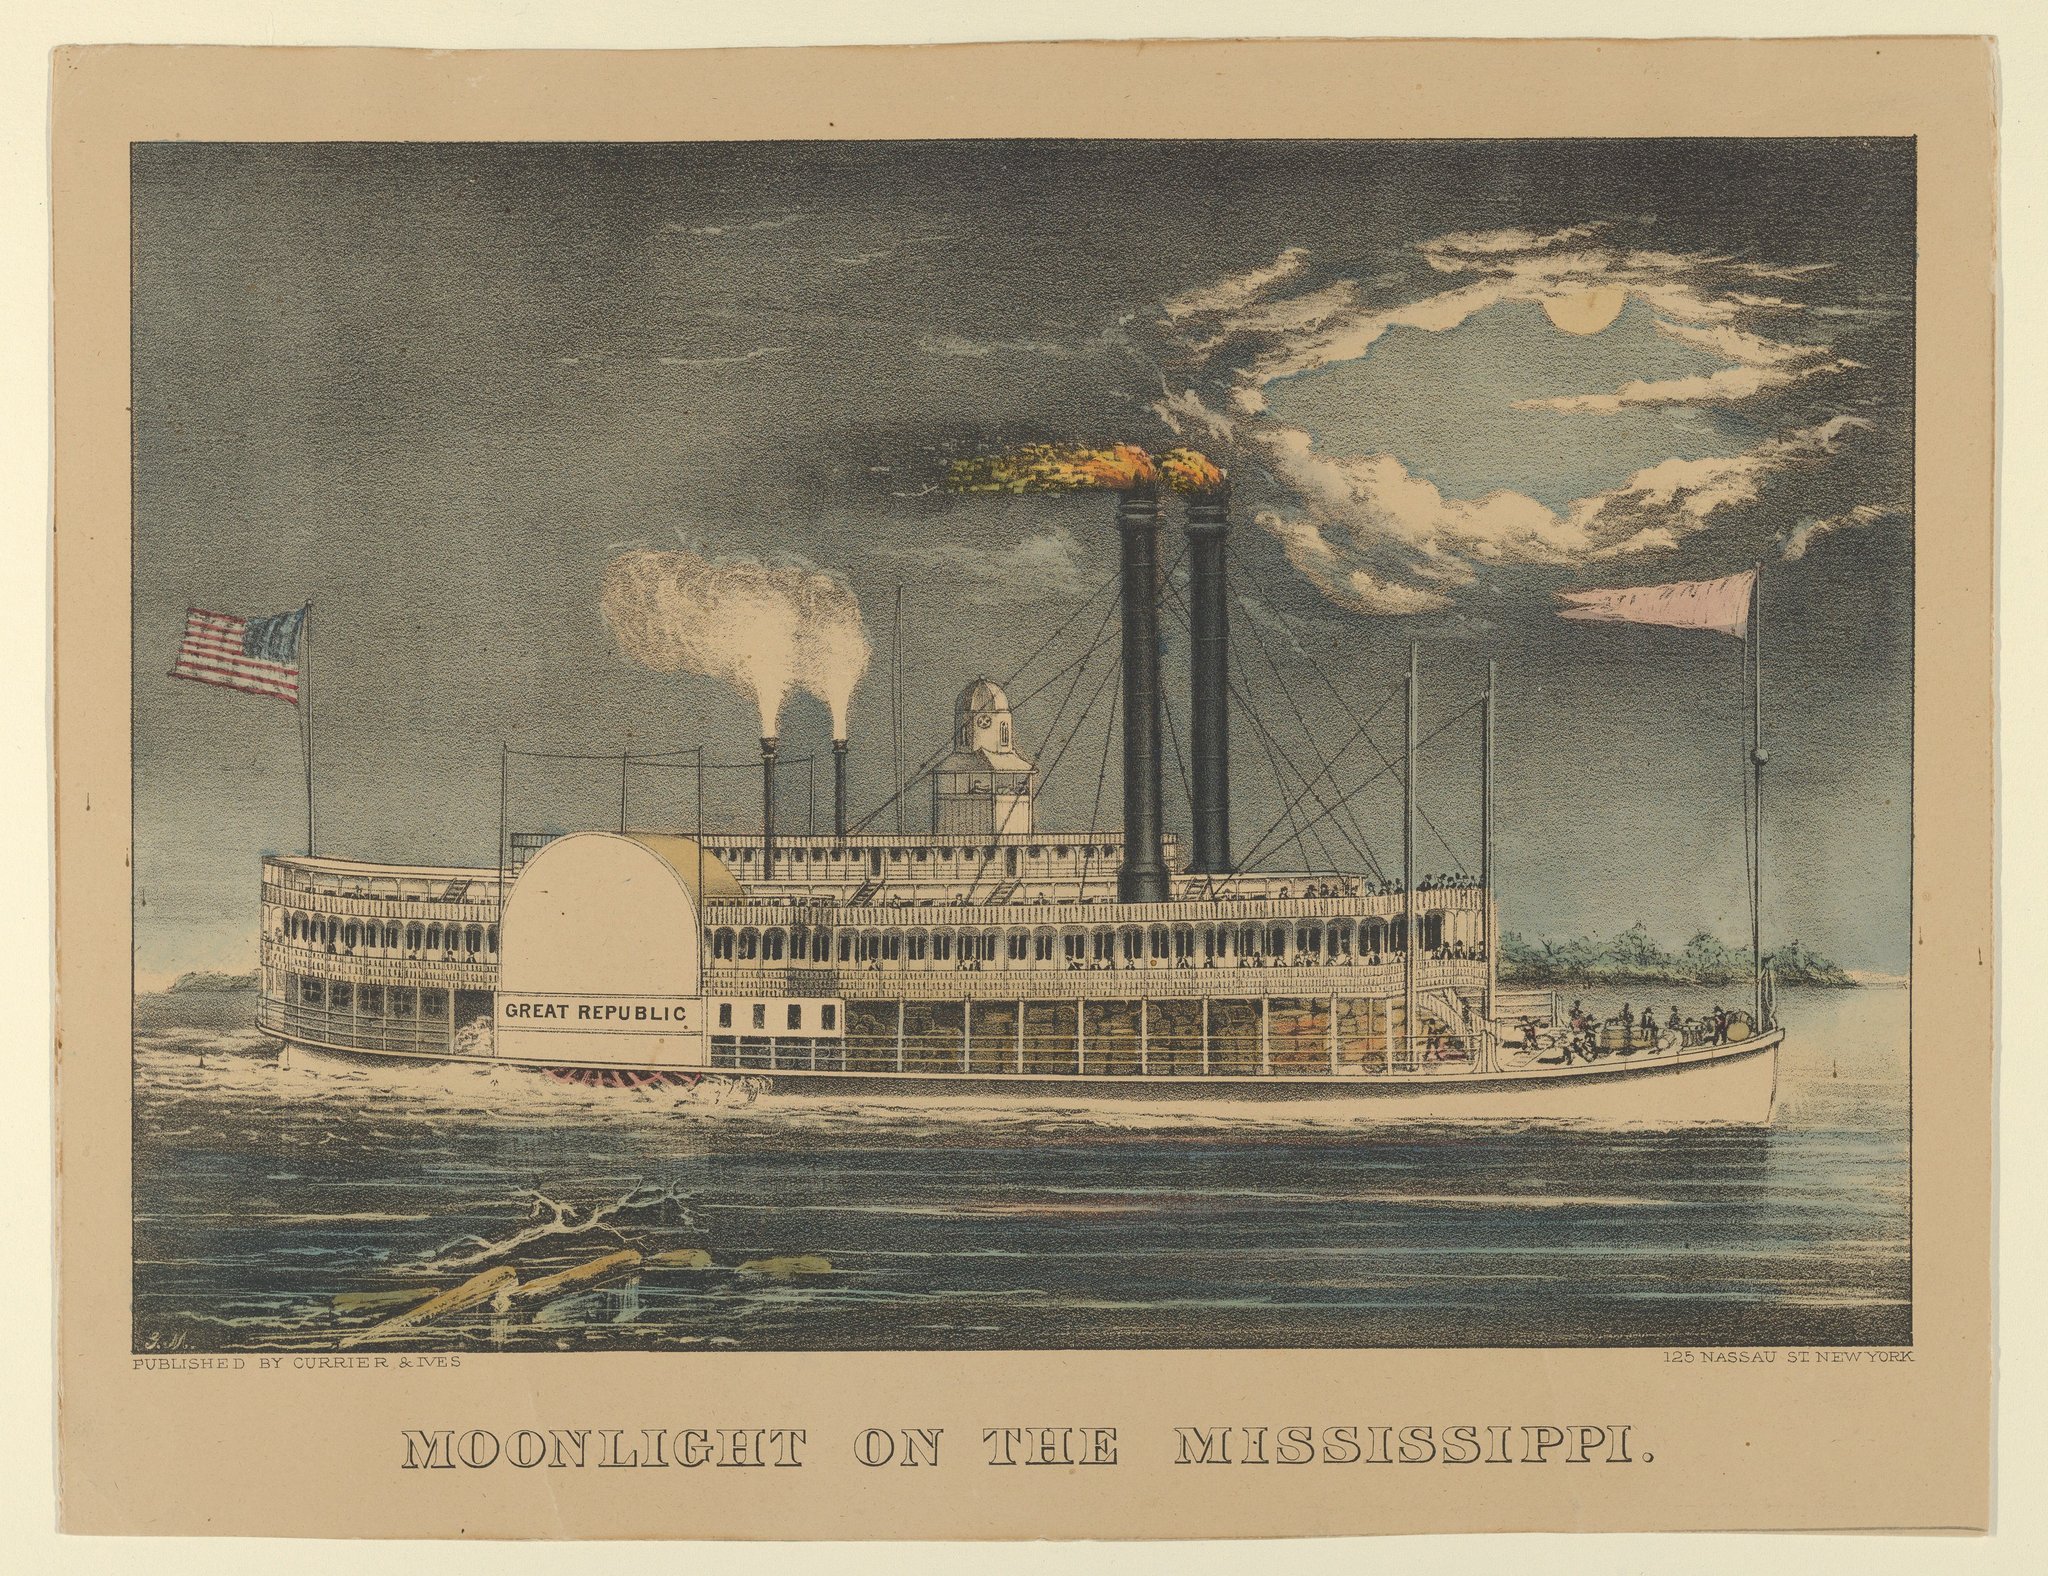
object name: print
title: Moonlight on the Mississippi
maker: currier & ives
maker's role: lithographer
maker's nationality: american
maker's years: 1857-1907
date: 1868-1878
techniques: hand coloring, lithograph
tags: rivers,night,flags,ships